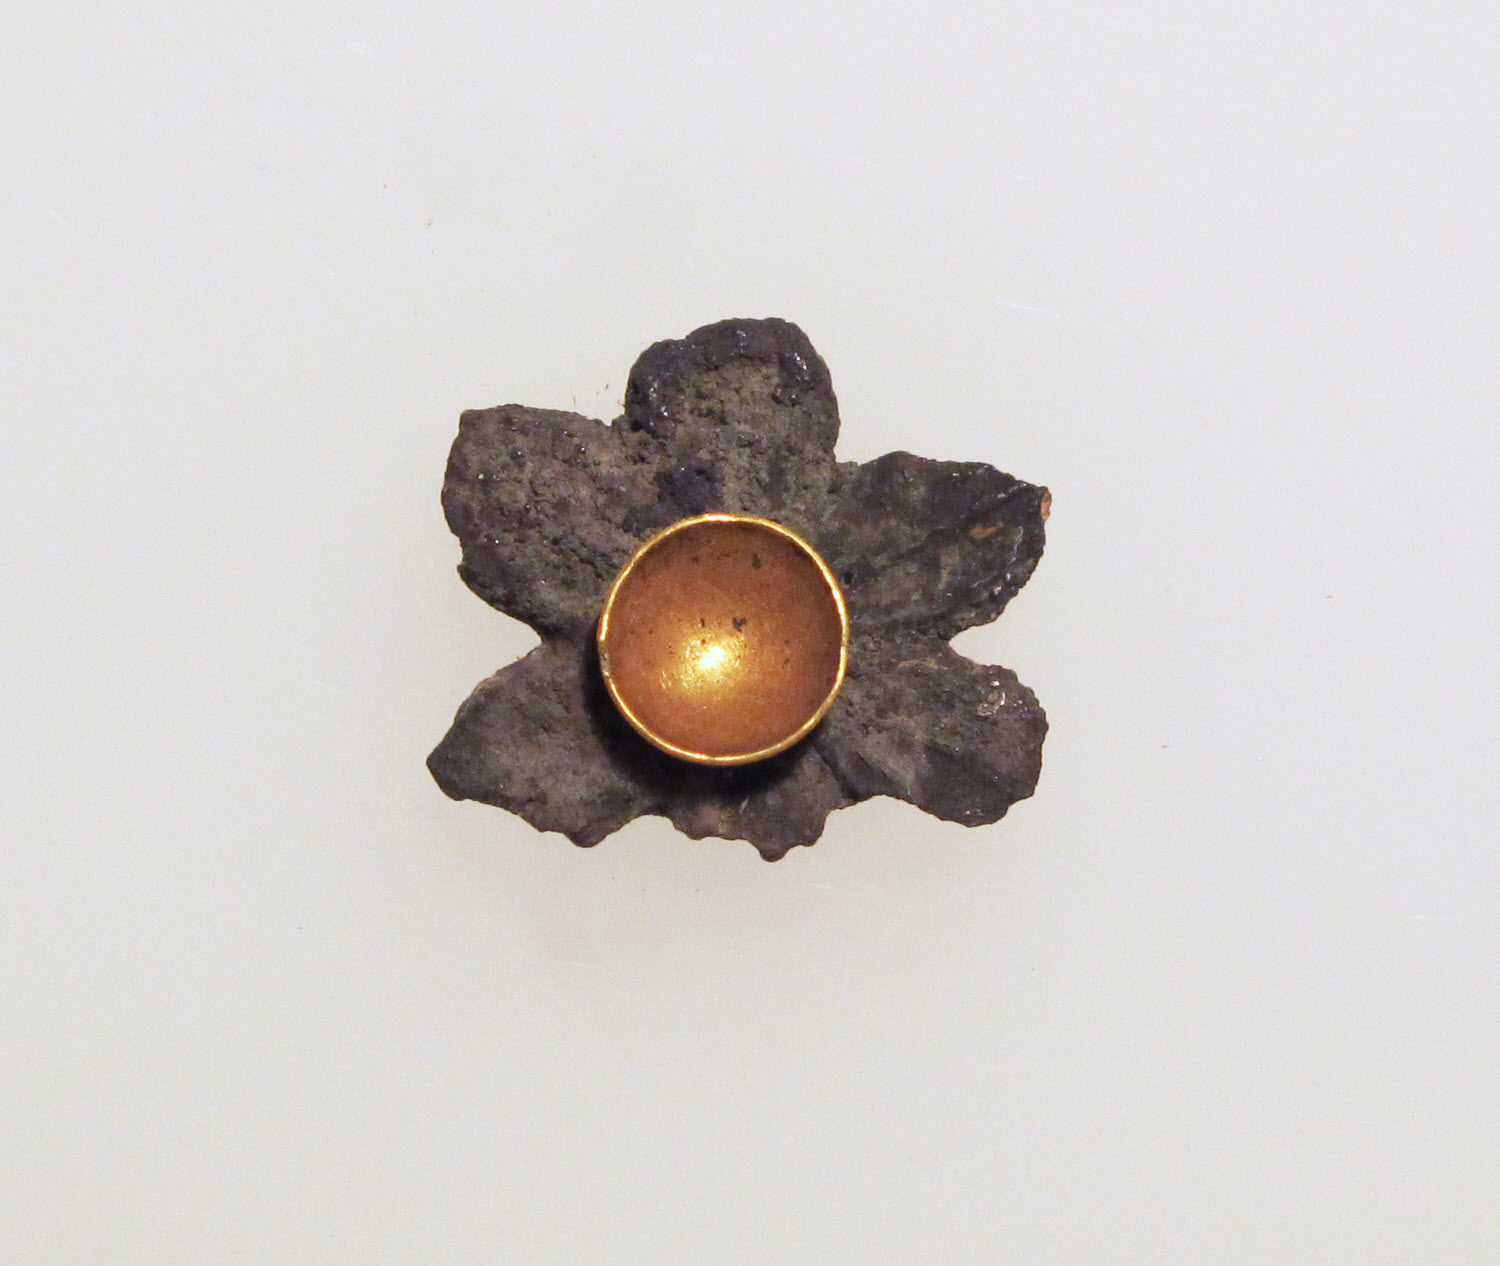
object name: bead in the form of a rosette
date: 7000 BCE-330 CE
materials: gold, silver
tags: roses